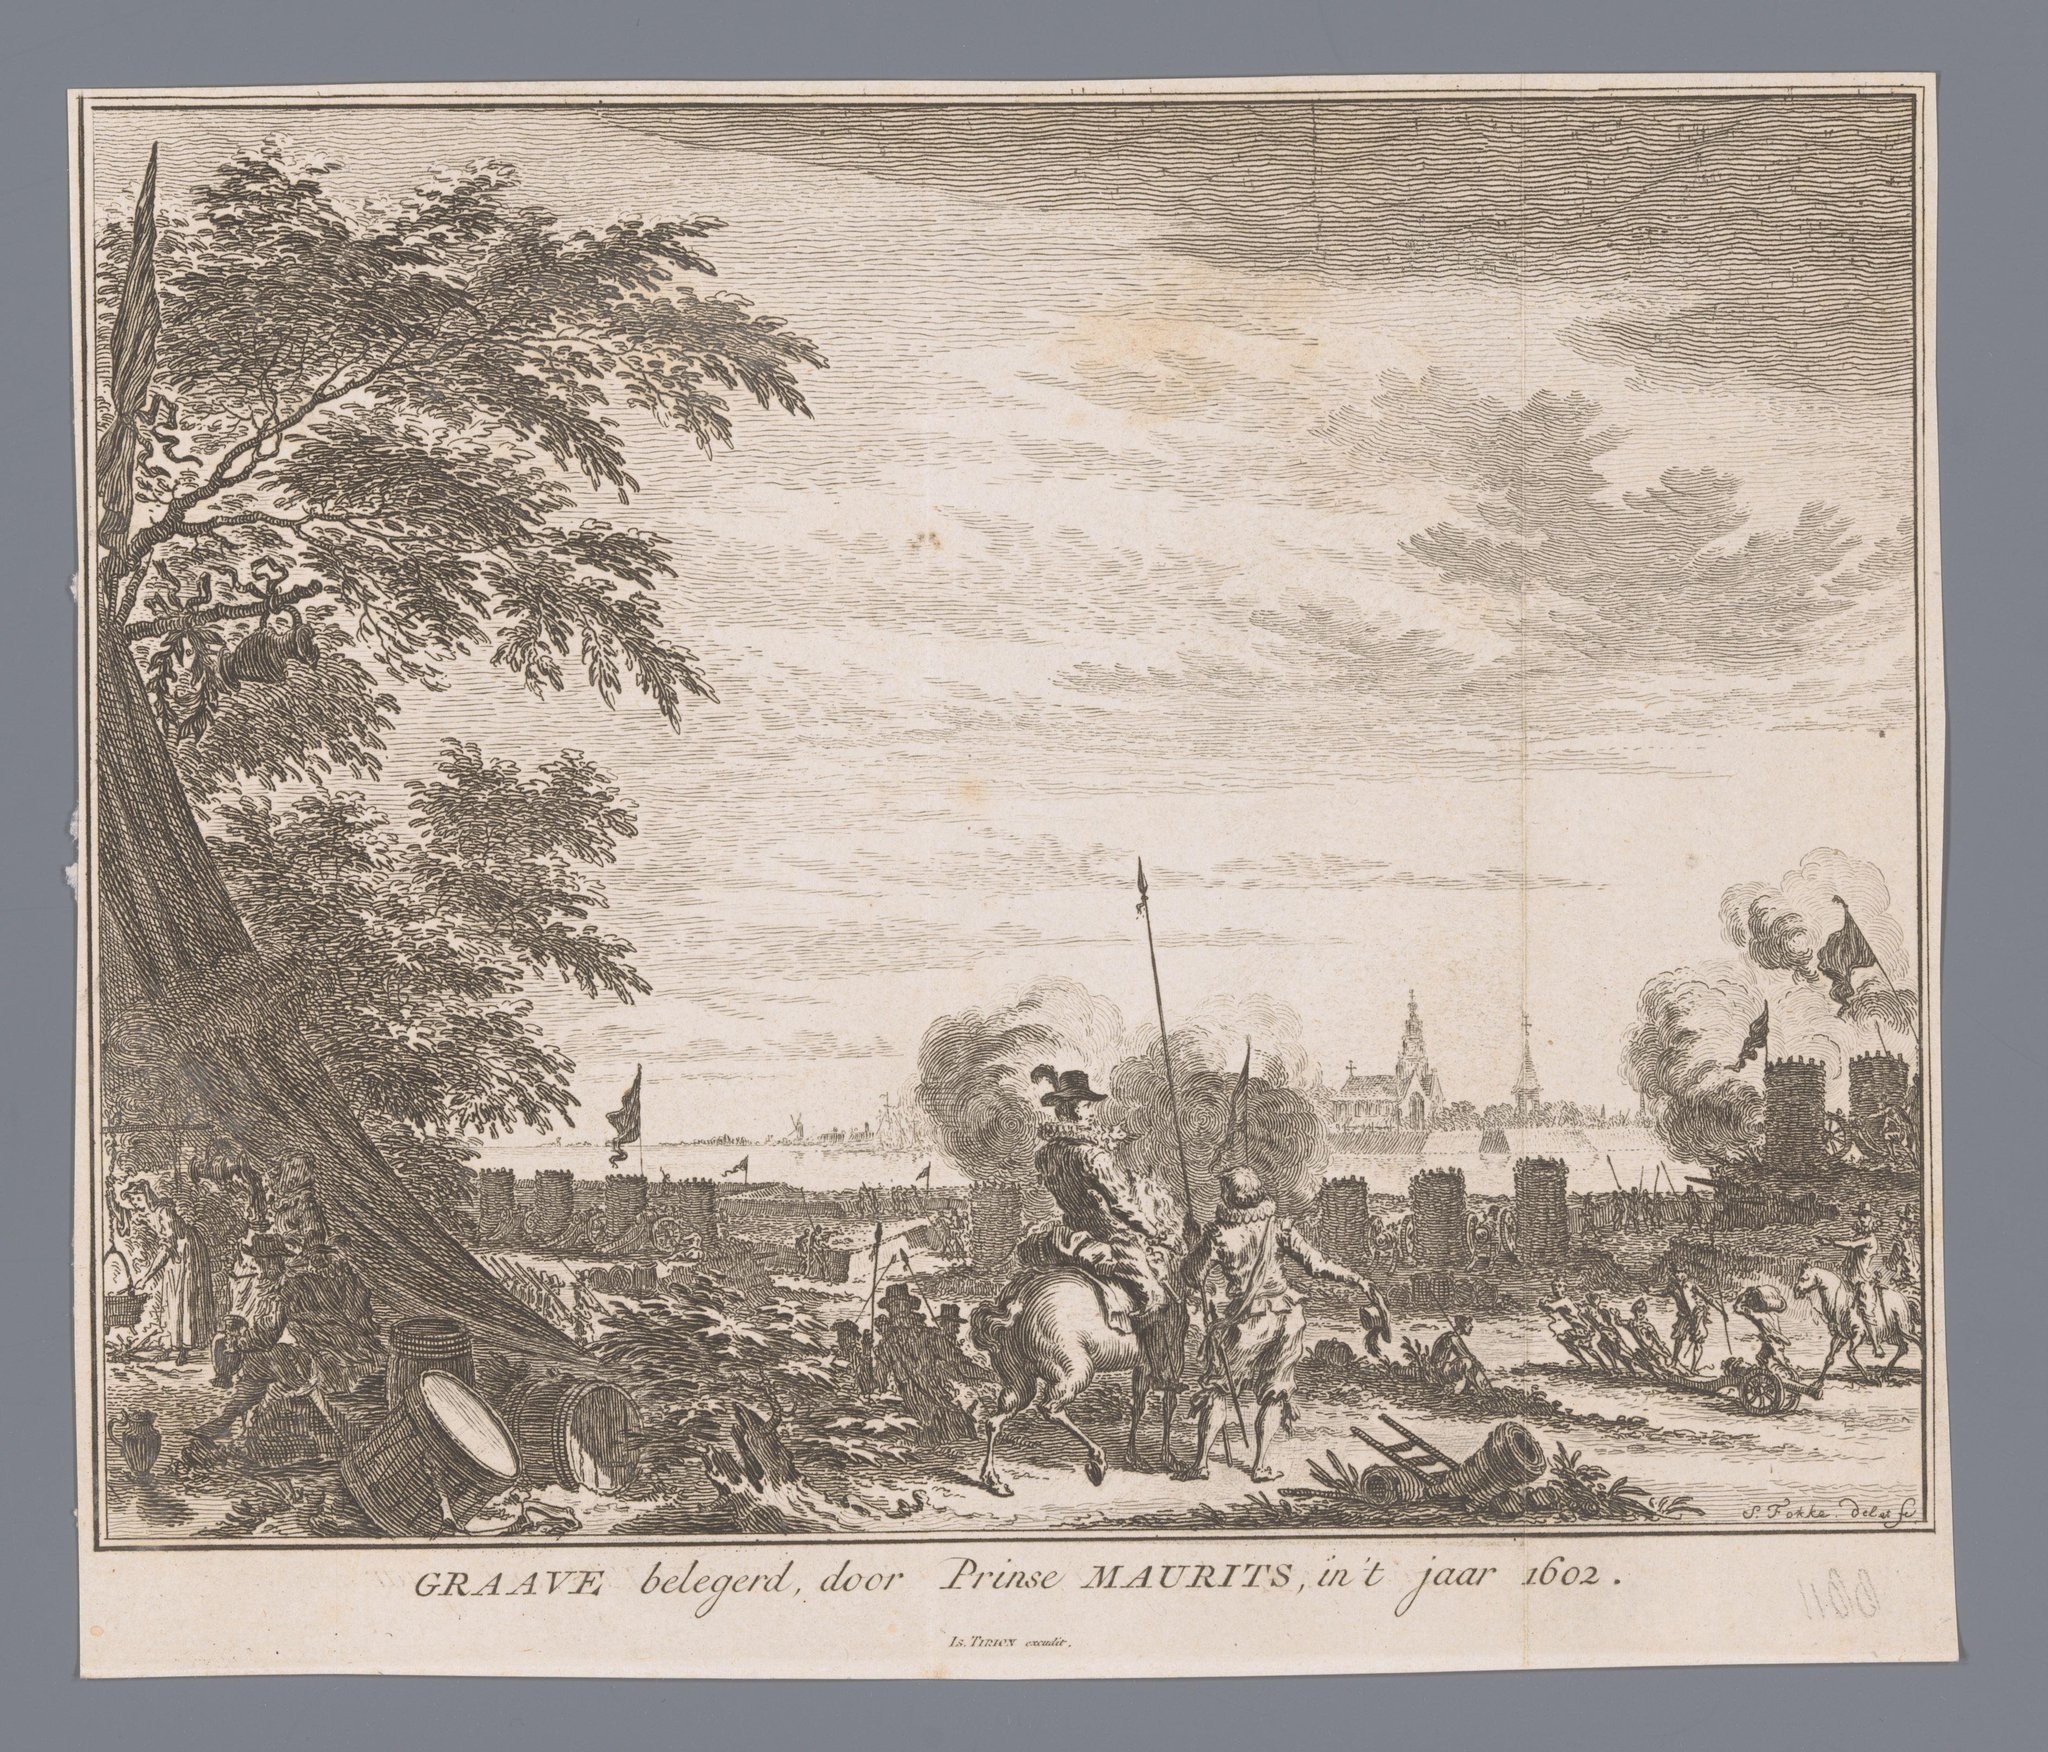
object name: book illustration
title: Graave belegerd, door Prinse Maurits, in 't jaar 1602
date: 1753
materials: paper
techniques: etching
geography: amsterdam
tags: siege, grave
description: Prent uit: Wagenaar, Jan. Vaderlandsche historie (...). 21 dln. Amsterdam: Isaak Tirion, 1753, dl. 9, p. 120-121.